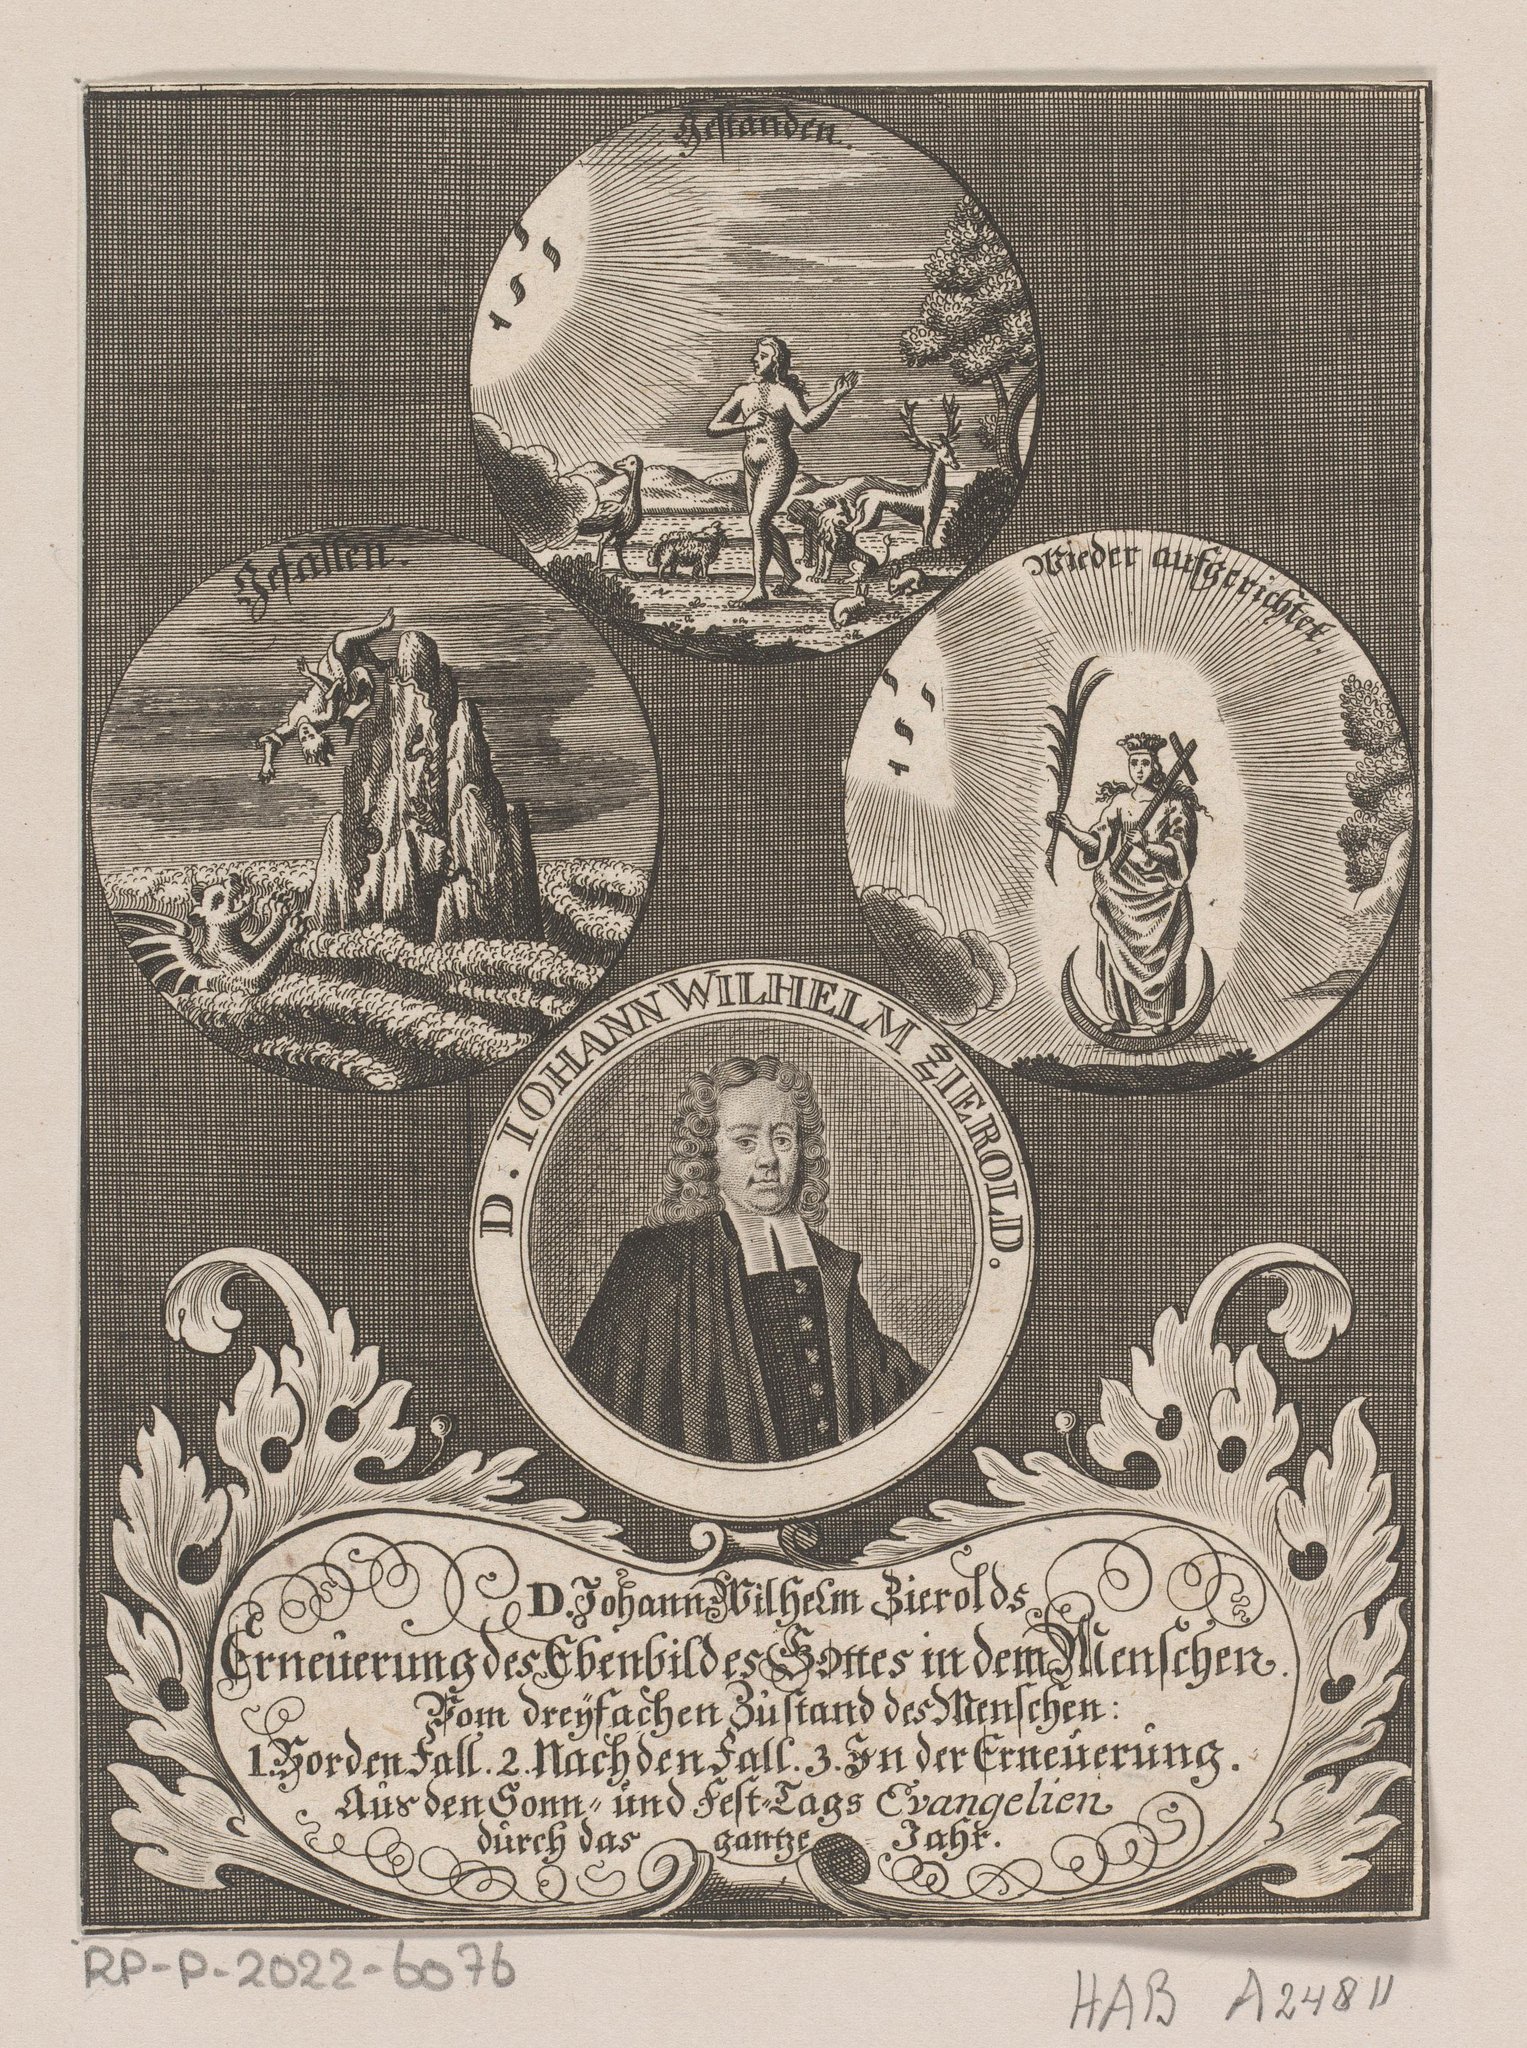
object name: print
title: Vier voorstellingen in een rond kader waarvan een met het portret van Johann Wilhelm Zierold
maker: Anonymous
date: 1700-1799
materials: paper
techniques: etching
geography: germany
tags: madonna on the crescent of the moon (sometimes called queen of heaven) (in mandorla), theologian, historical persons, portrait of a writer, garden of eden, paradise, falling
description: Met zesregelig onderschrift in het Duits.